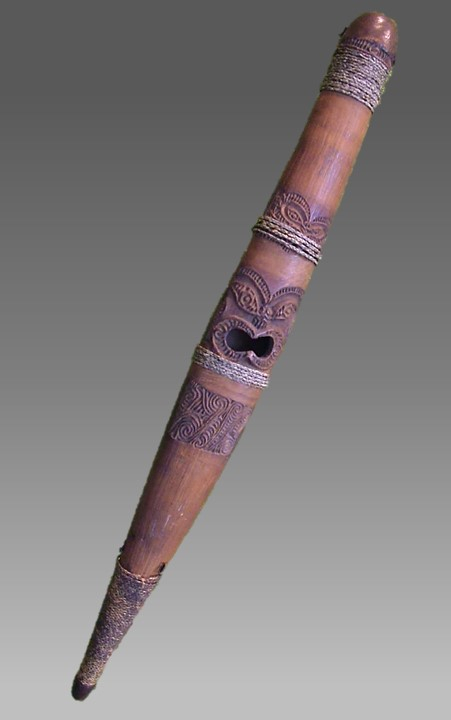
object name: pūtōrino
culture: maori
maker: maori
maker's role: culture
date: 1867-1900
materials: cord, wood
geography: new zealand